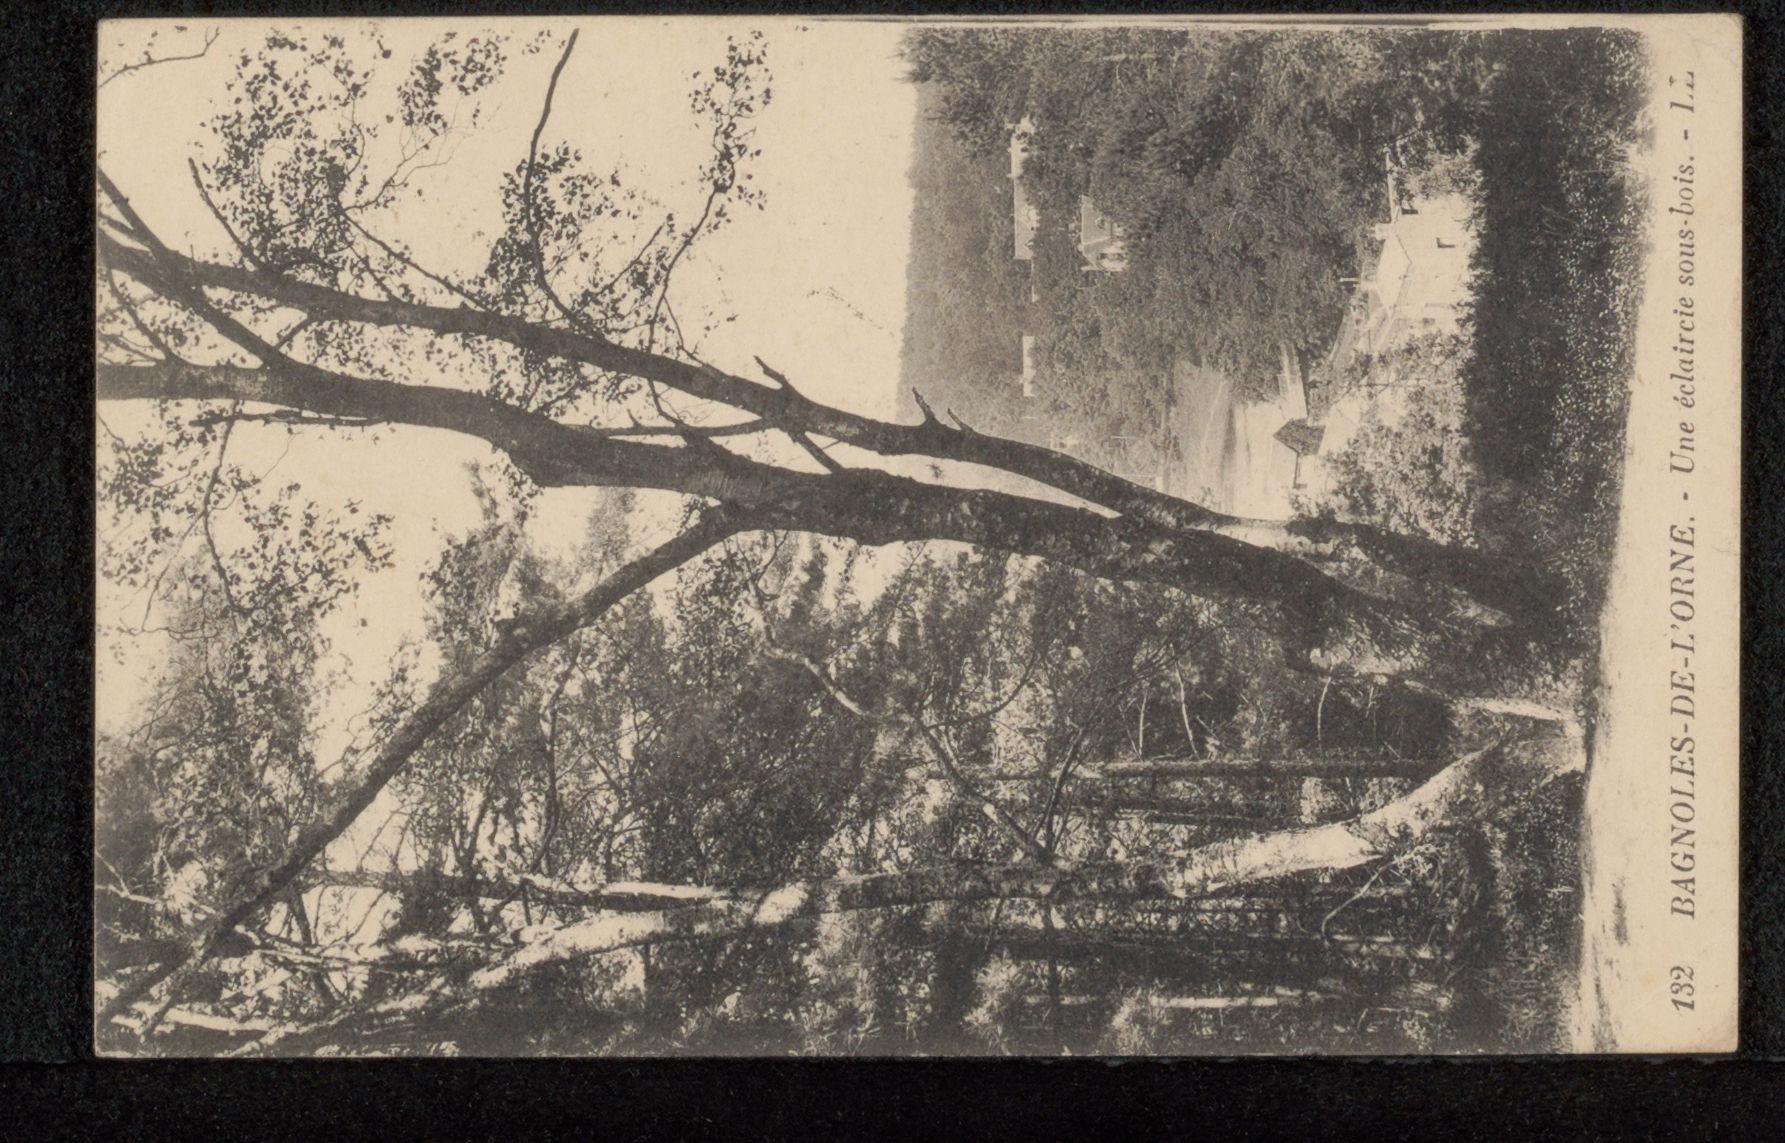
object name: ansichtkaart, prentbriefkaart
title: Prentbriefkaart aan Philip Zilcken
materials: cardboard, ink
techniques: photograph, pen, writing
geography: paris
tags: the hague, painter, draughtsman, philip zilcken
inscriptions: collector's mark: ‘RPK’